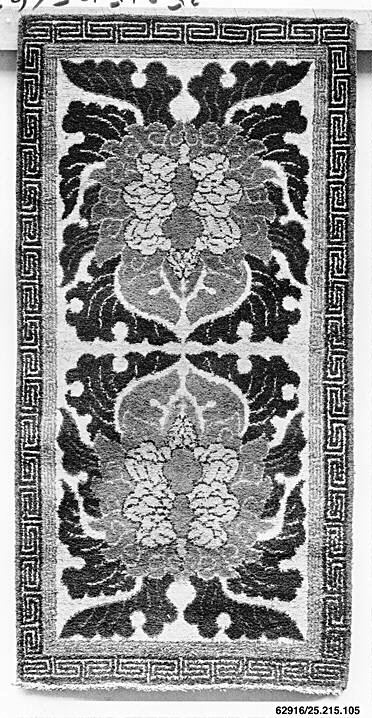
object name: carpet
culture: japanese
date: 1701-1800